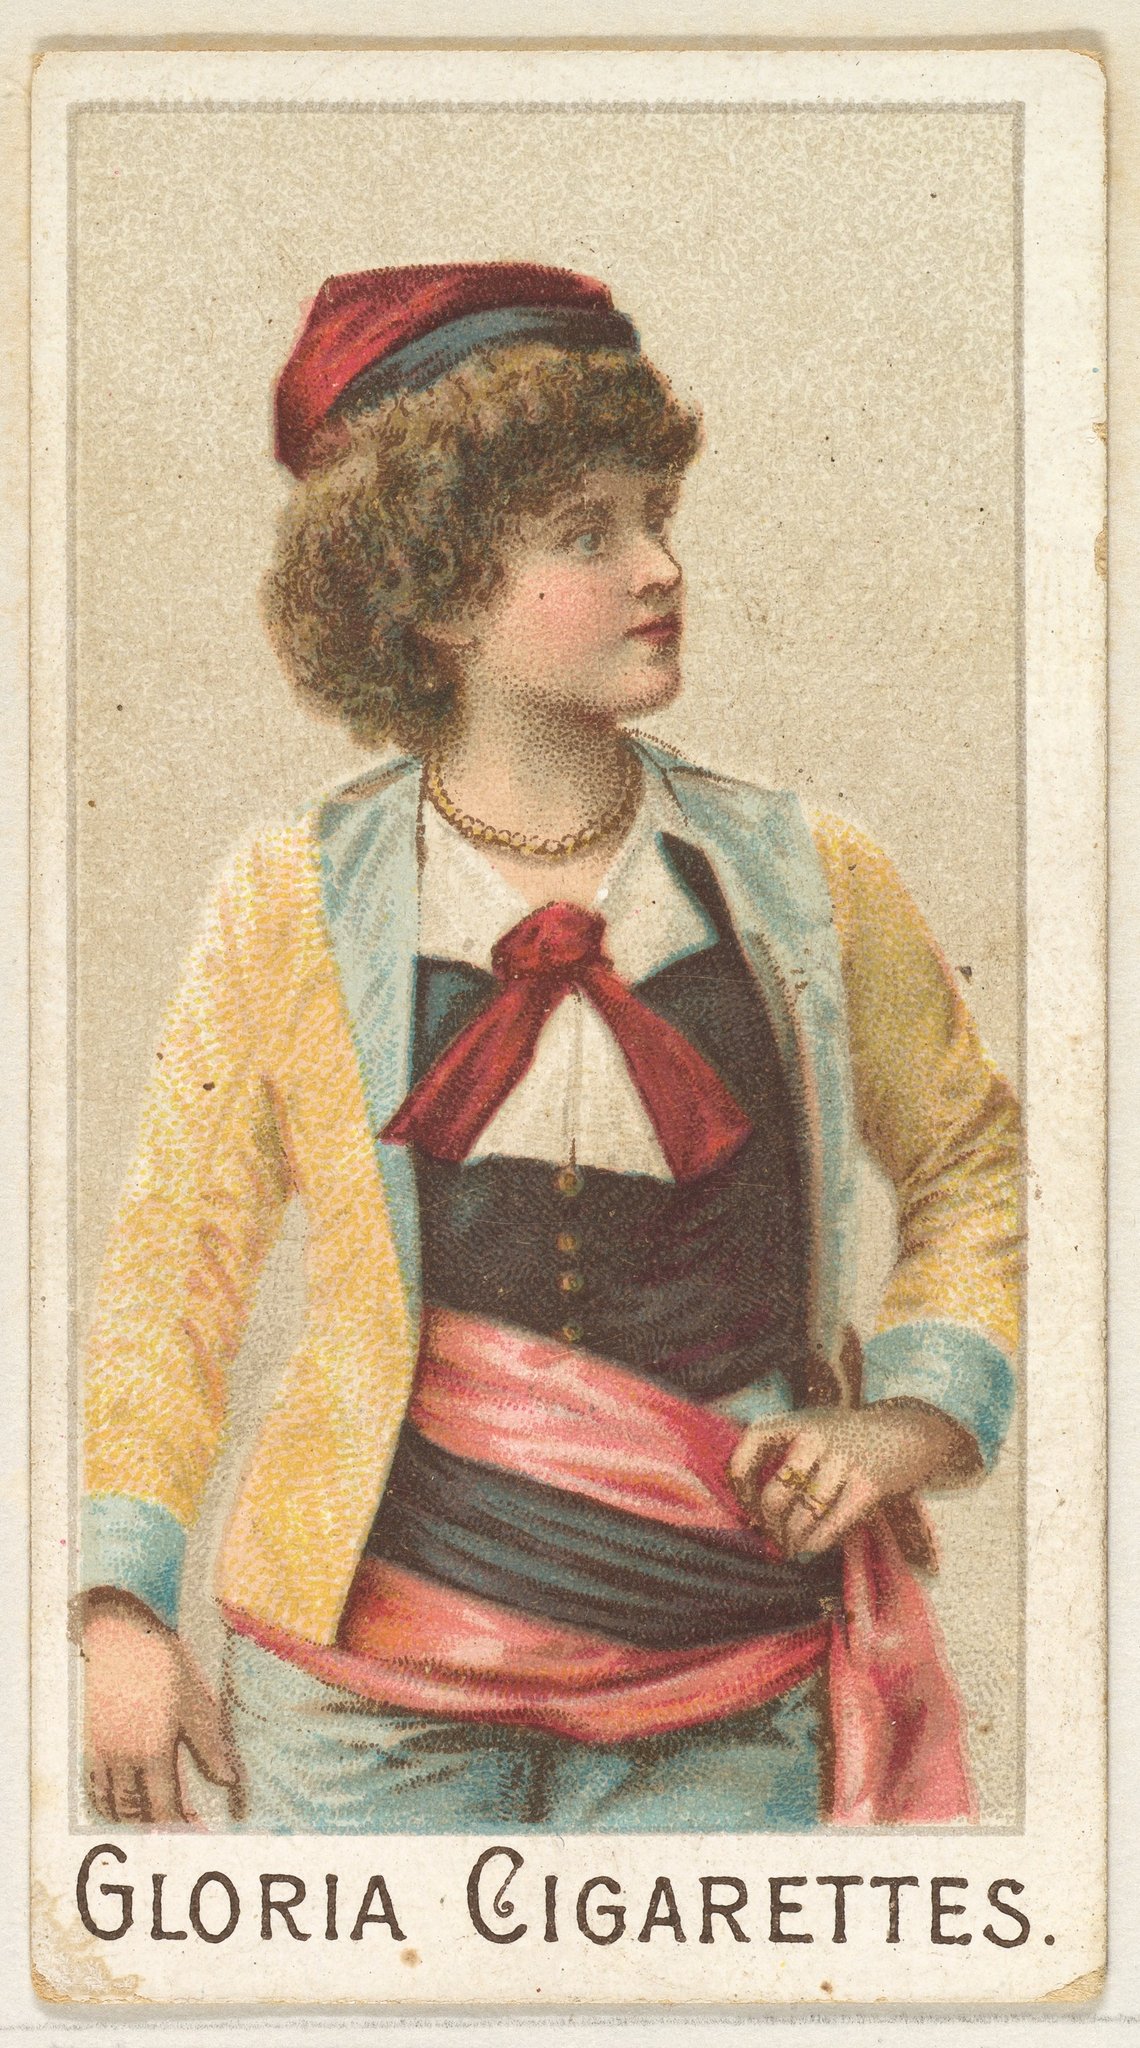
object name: print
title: From the series "Sports Girls" (C190), issued by the American Cigarette Company, Ltd., Montreal, to promote Gloria Cigarettes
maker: american cigarette company, ltd.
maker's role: publisher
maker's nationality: canadian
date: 1889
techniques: color lithograph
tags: girls